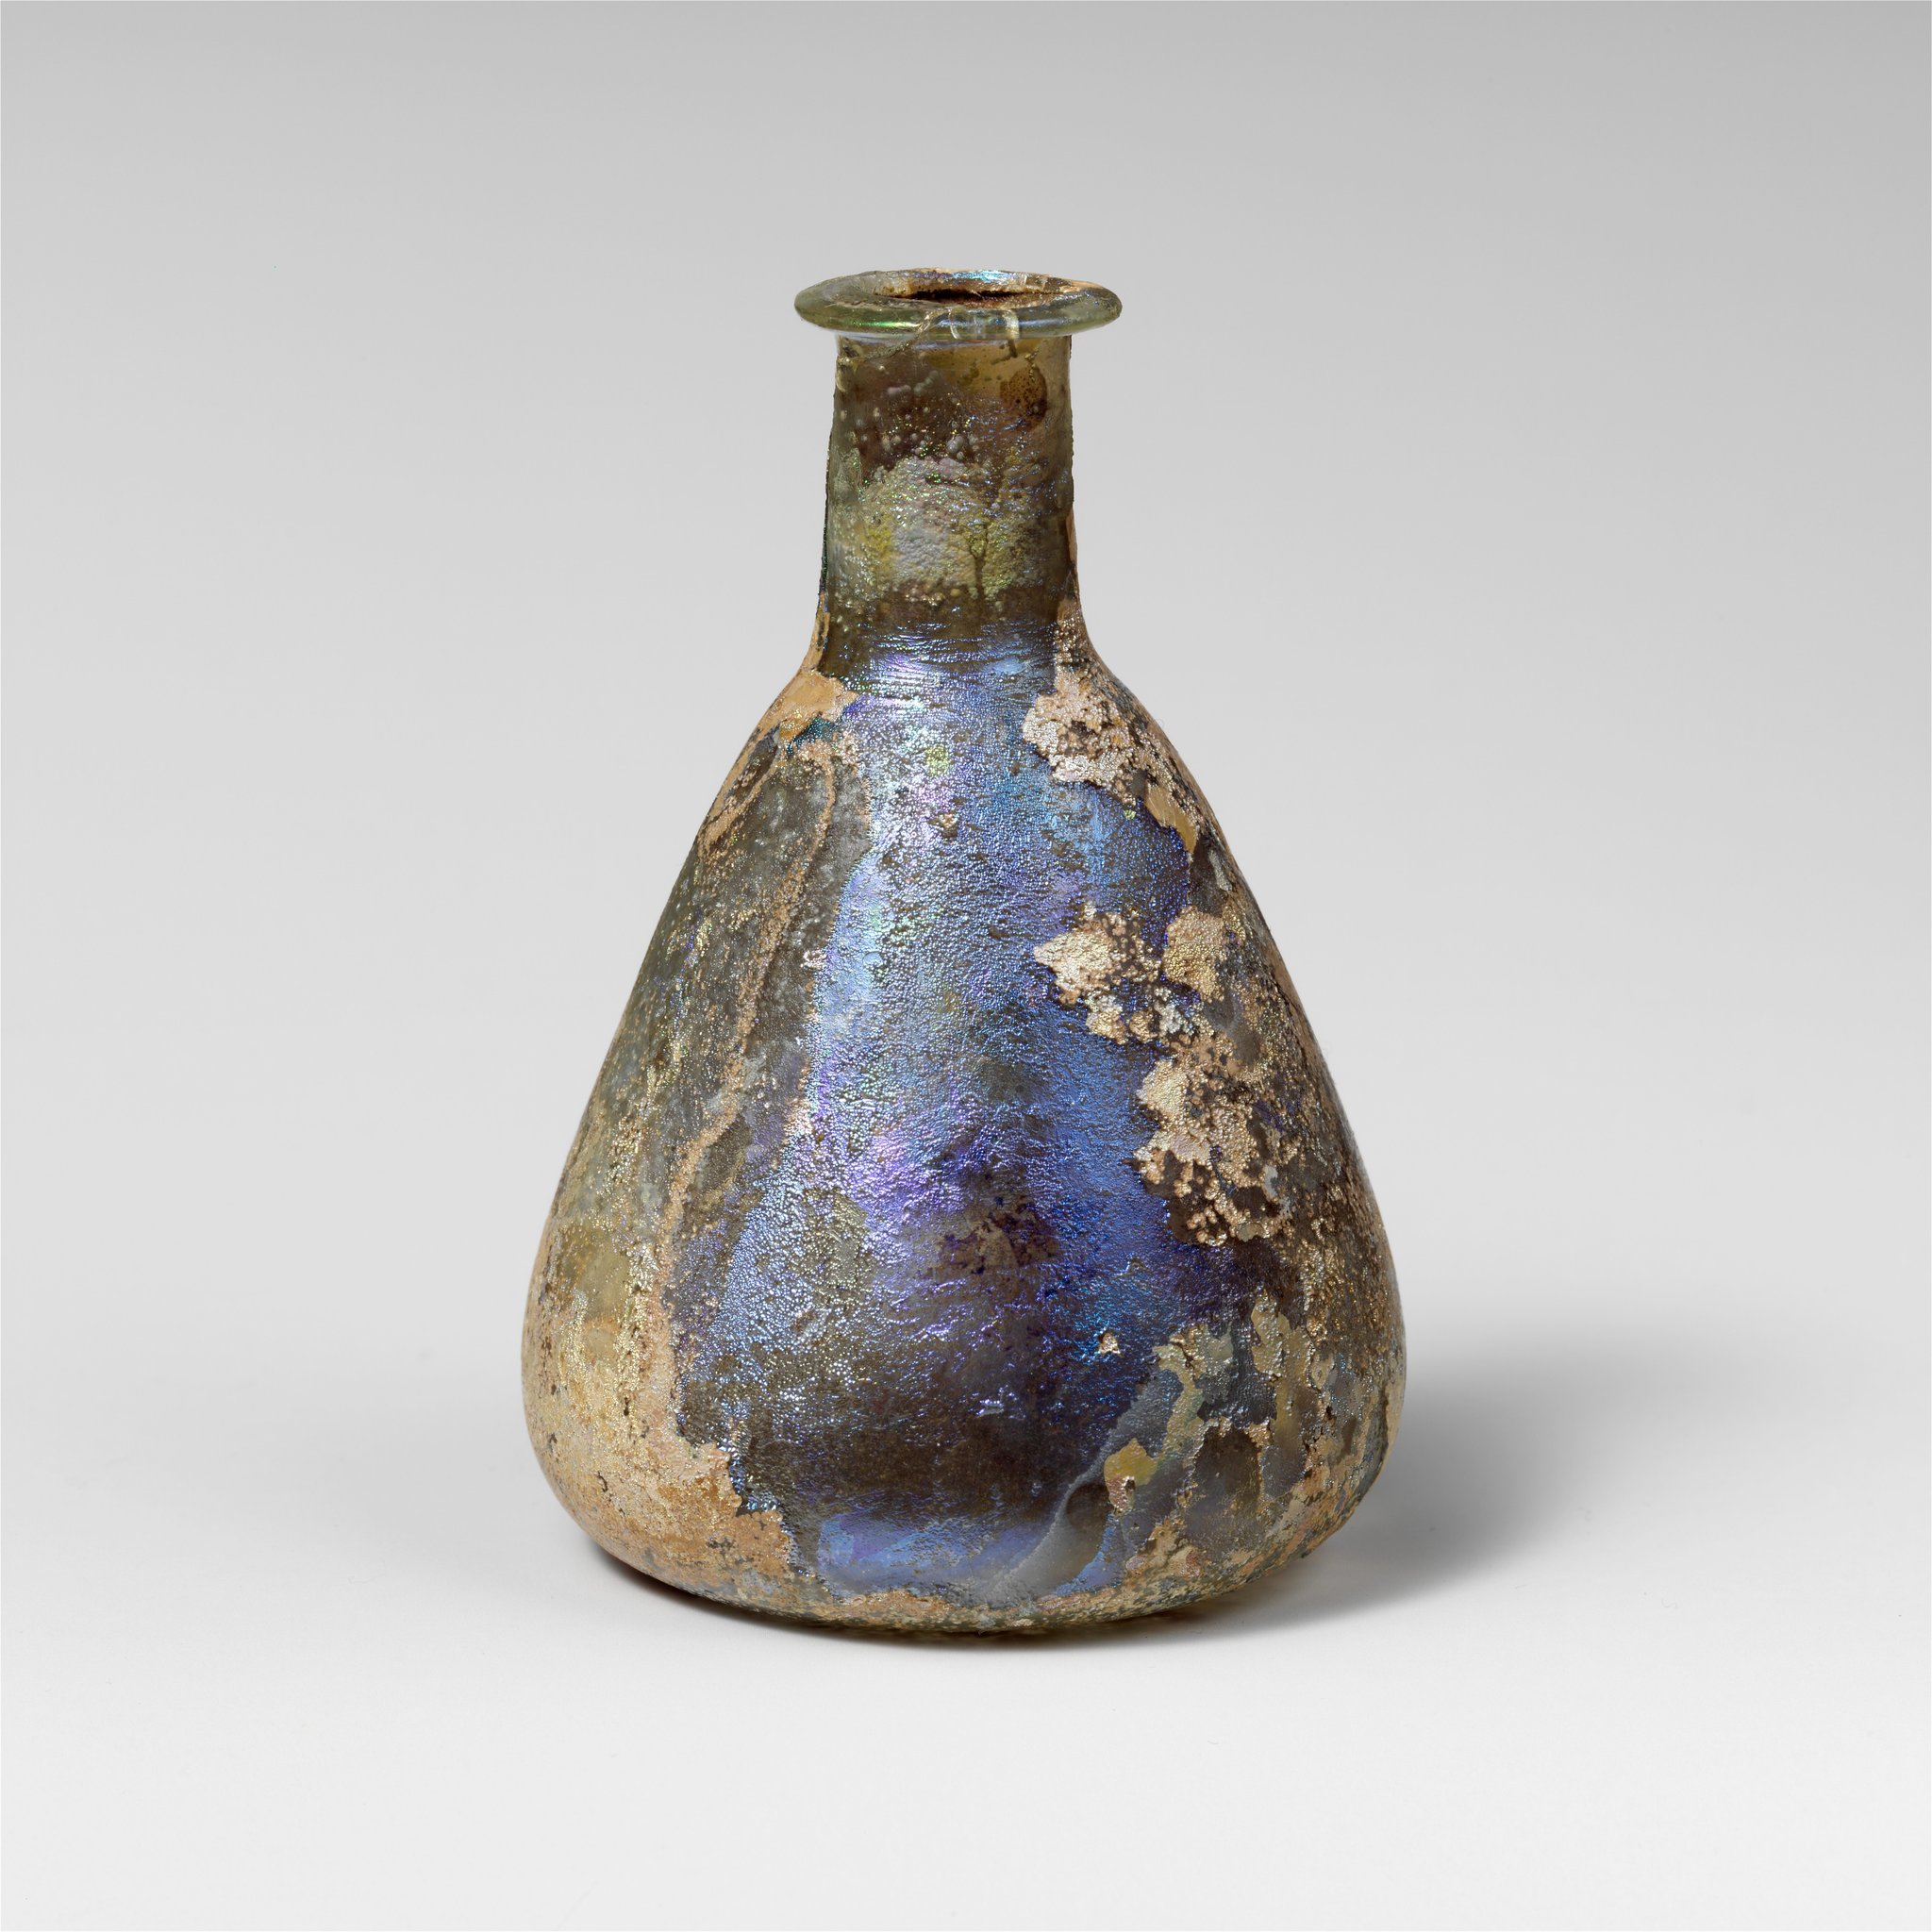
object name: perfume bottle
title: Glass perfume bottle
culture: roman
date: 1-100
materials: glass